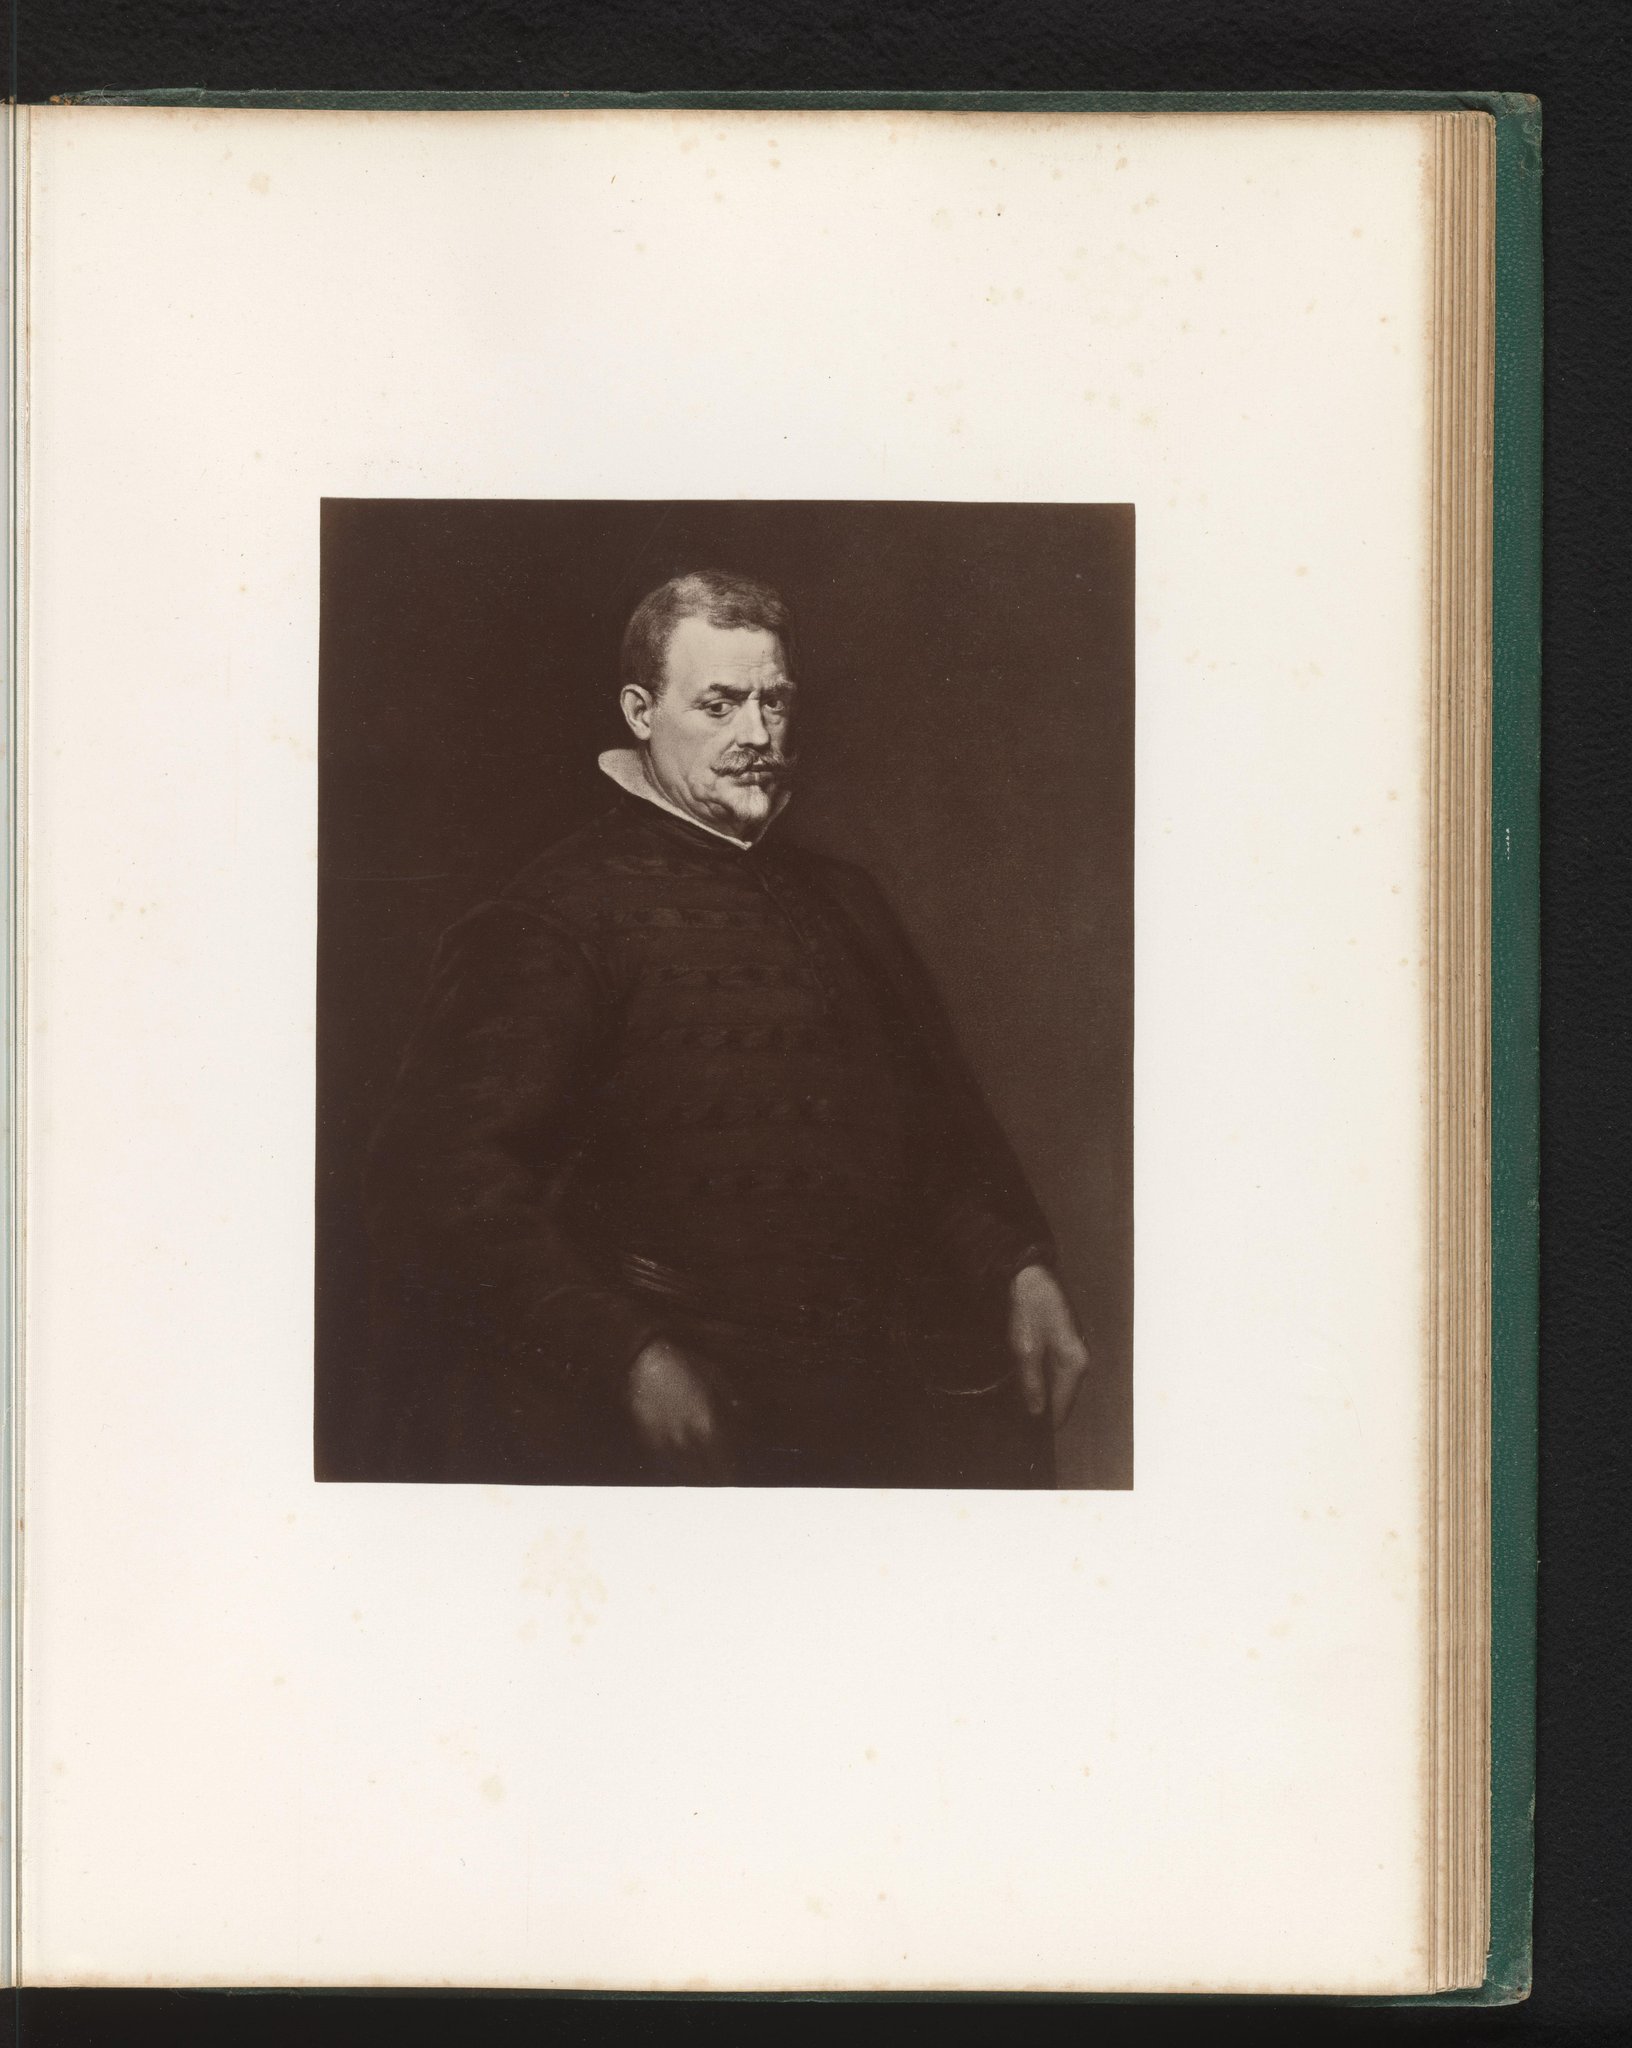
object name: page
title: D. Velasquez: Männliches Bildniss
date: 1870-1875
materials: paper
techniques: albumen print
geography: berlin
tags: historical persons